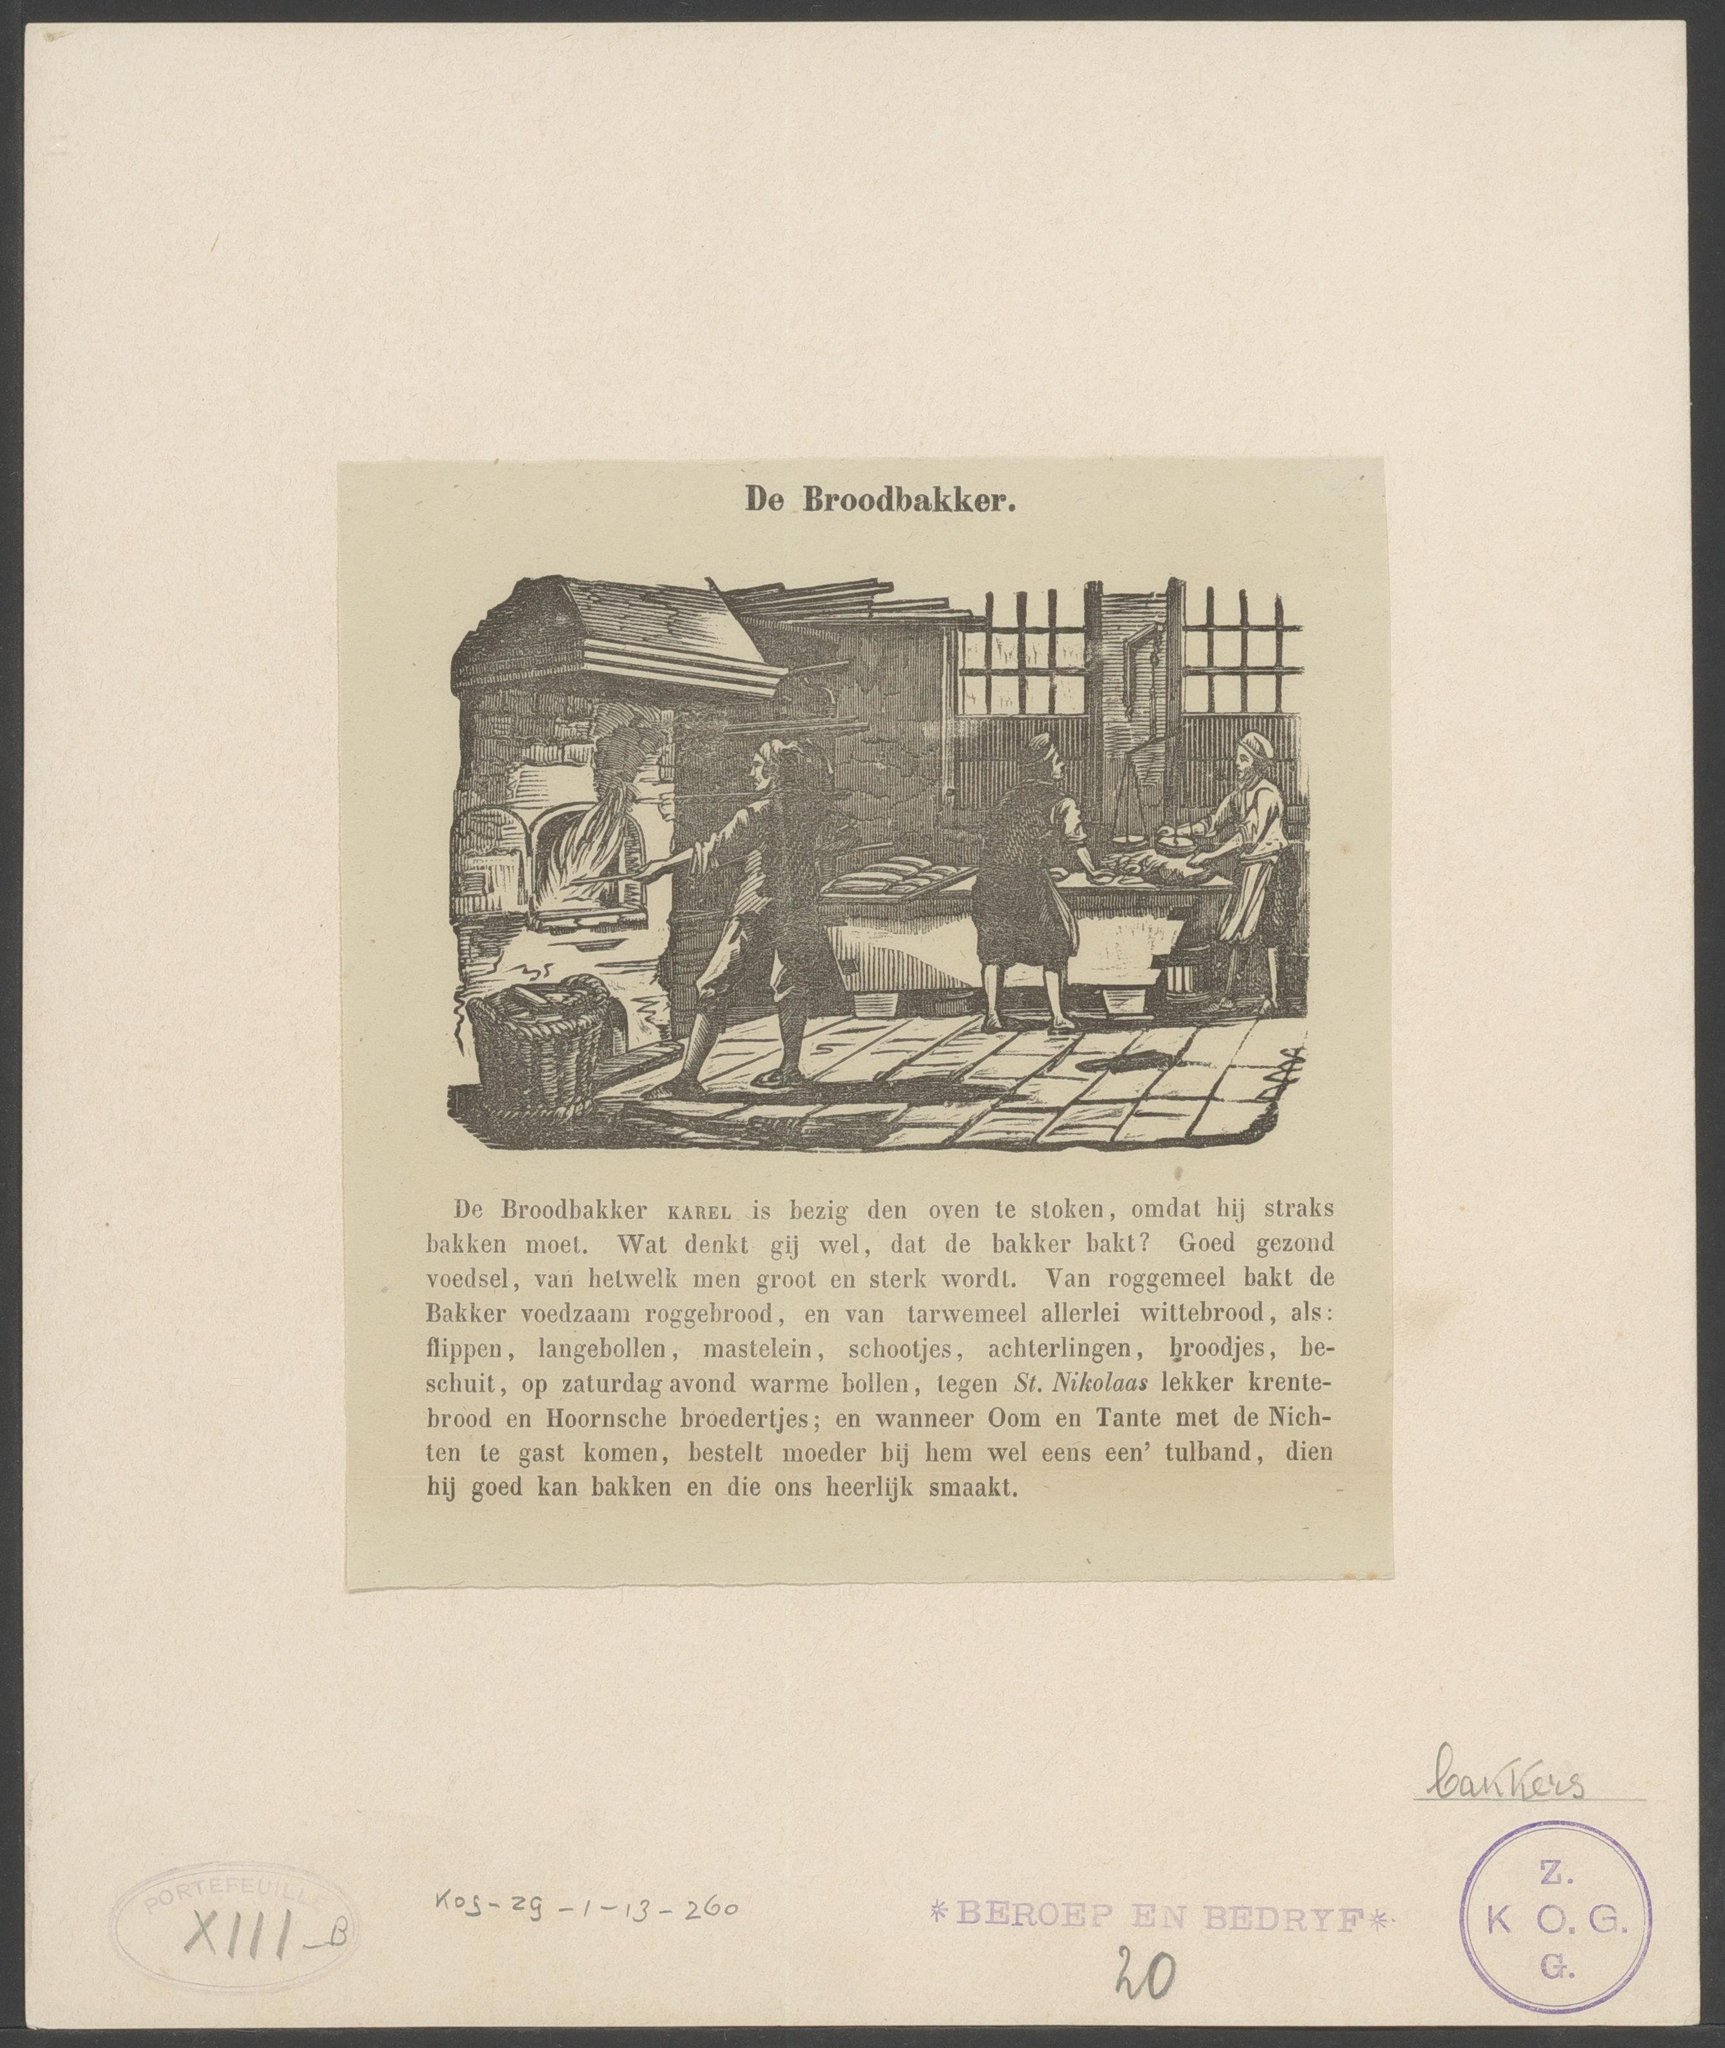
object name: print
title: Bakker aan het werk in de bakkerij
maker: Anonymous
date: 1850-1855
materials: paper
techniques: letterpress printing, engraving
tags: baker (+ place ~ crafts, industries, agriculture), baker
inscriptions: collector's mark: Lugt 1641, stamp, stamp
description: Prent waarschijnlijk geknipt uit een grotere volksprent uit de serie Prenten-magazijn voor de jeugd (zie RP-P-OB-206.130). Na voltooiing van de acht jaargangen van de reeks 'Prenten-magazijn voor de jeugd' in 1850 heeft Jan Schuitemaker al deze prenten heruitgegeven en omgenummerd als nr. 1 t/m 192. De oorspronkelijke jaargang wordt telkens nog vermeld rechtsonder op de prent. Binnen de jaargangen zijn prenten van hetzelfde thema in clusters van vier achter elkaar gezet.